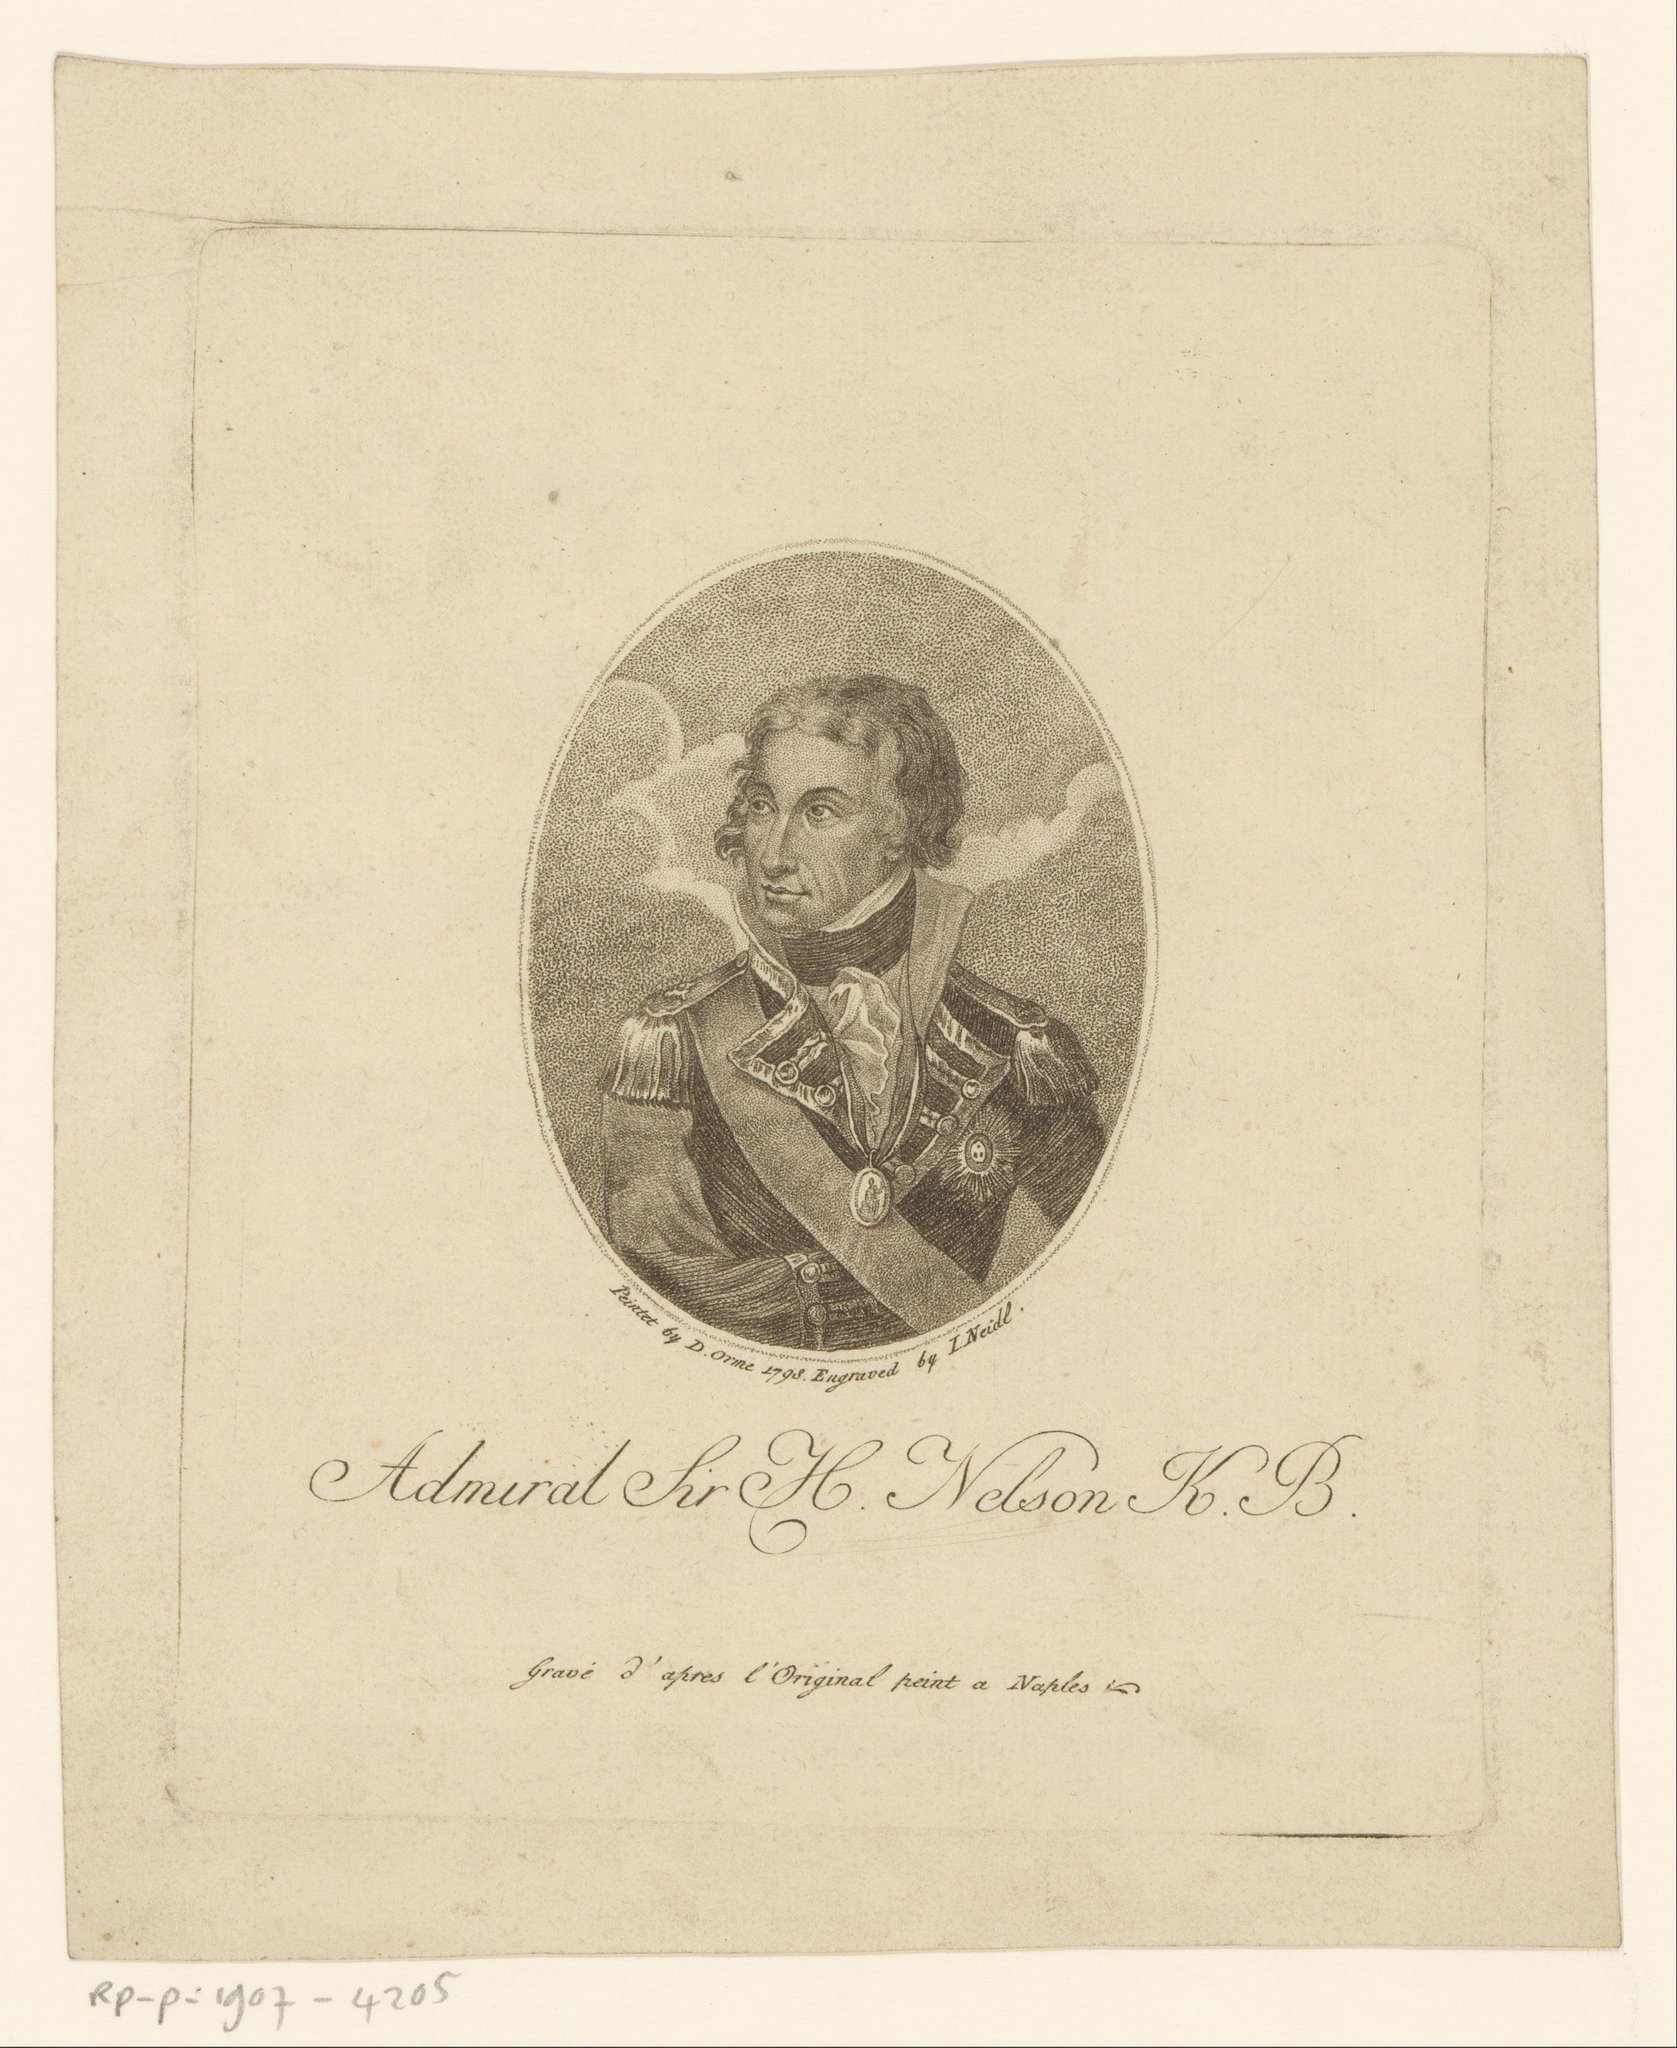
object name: print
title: Portret van Horatio Nelson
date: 1786-1832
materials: paper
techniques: engraving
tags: horatio nelson (hertog van bronte), historical persons, medals and other marks of military honour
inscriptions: collector's mark: Lugt 2228